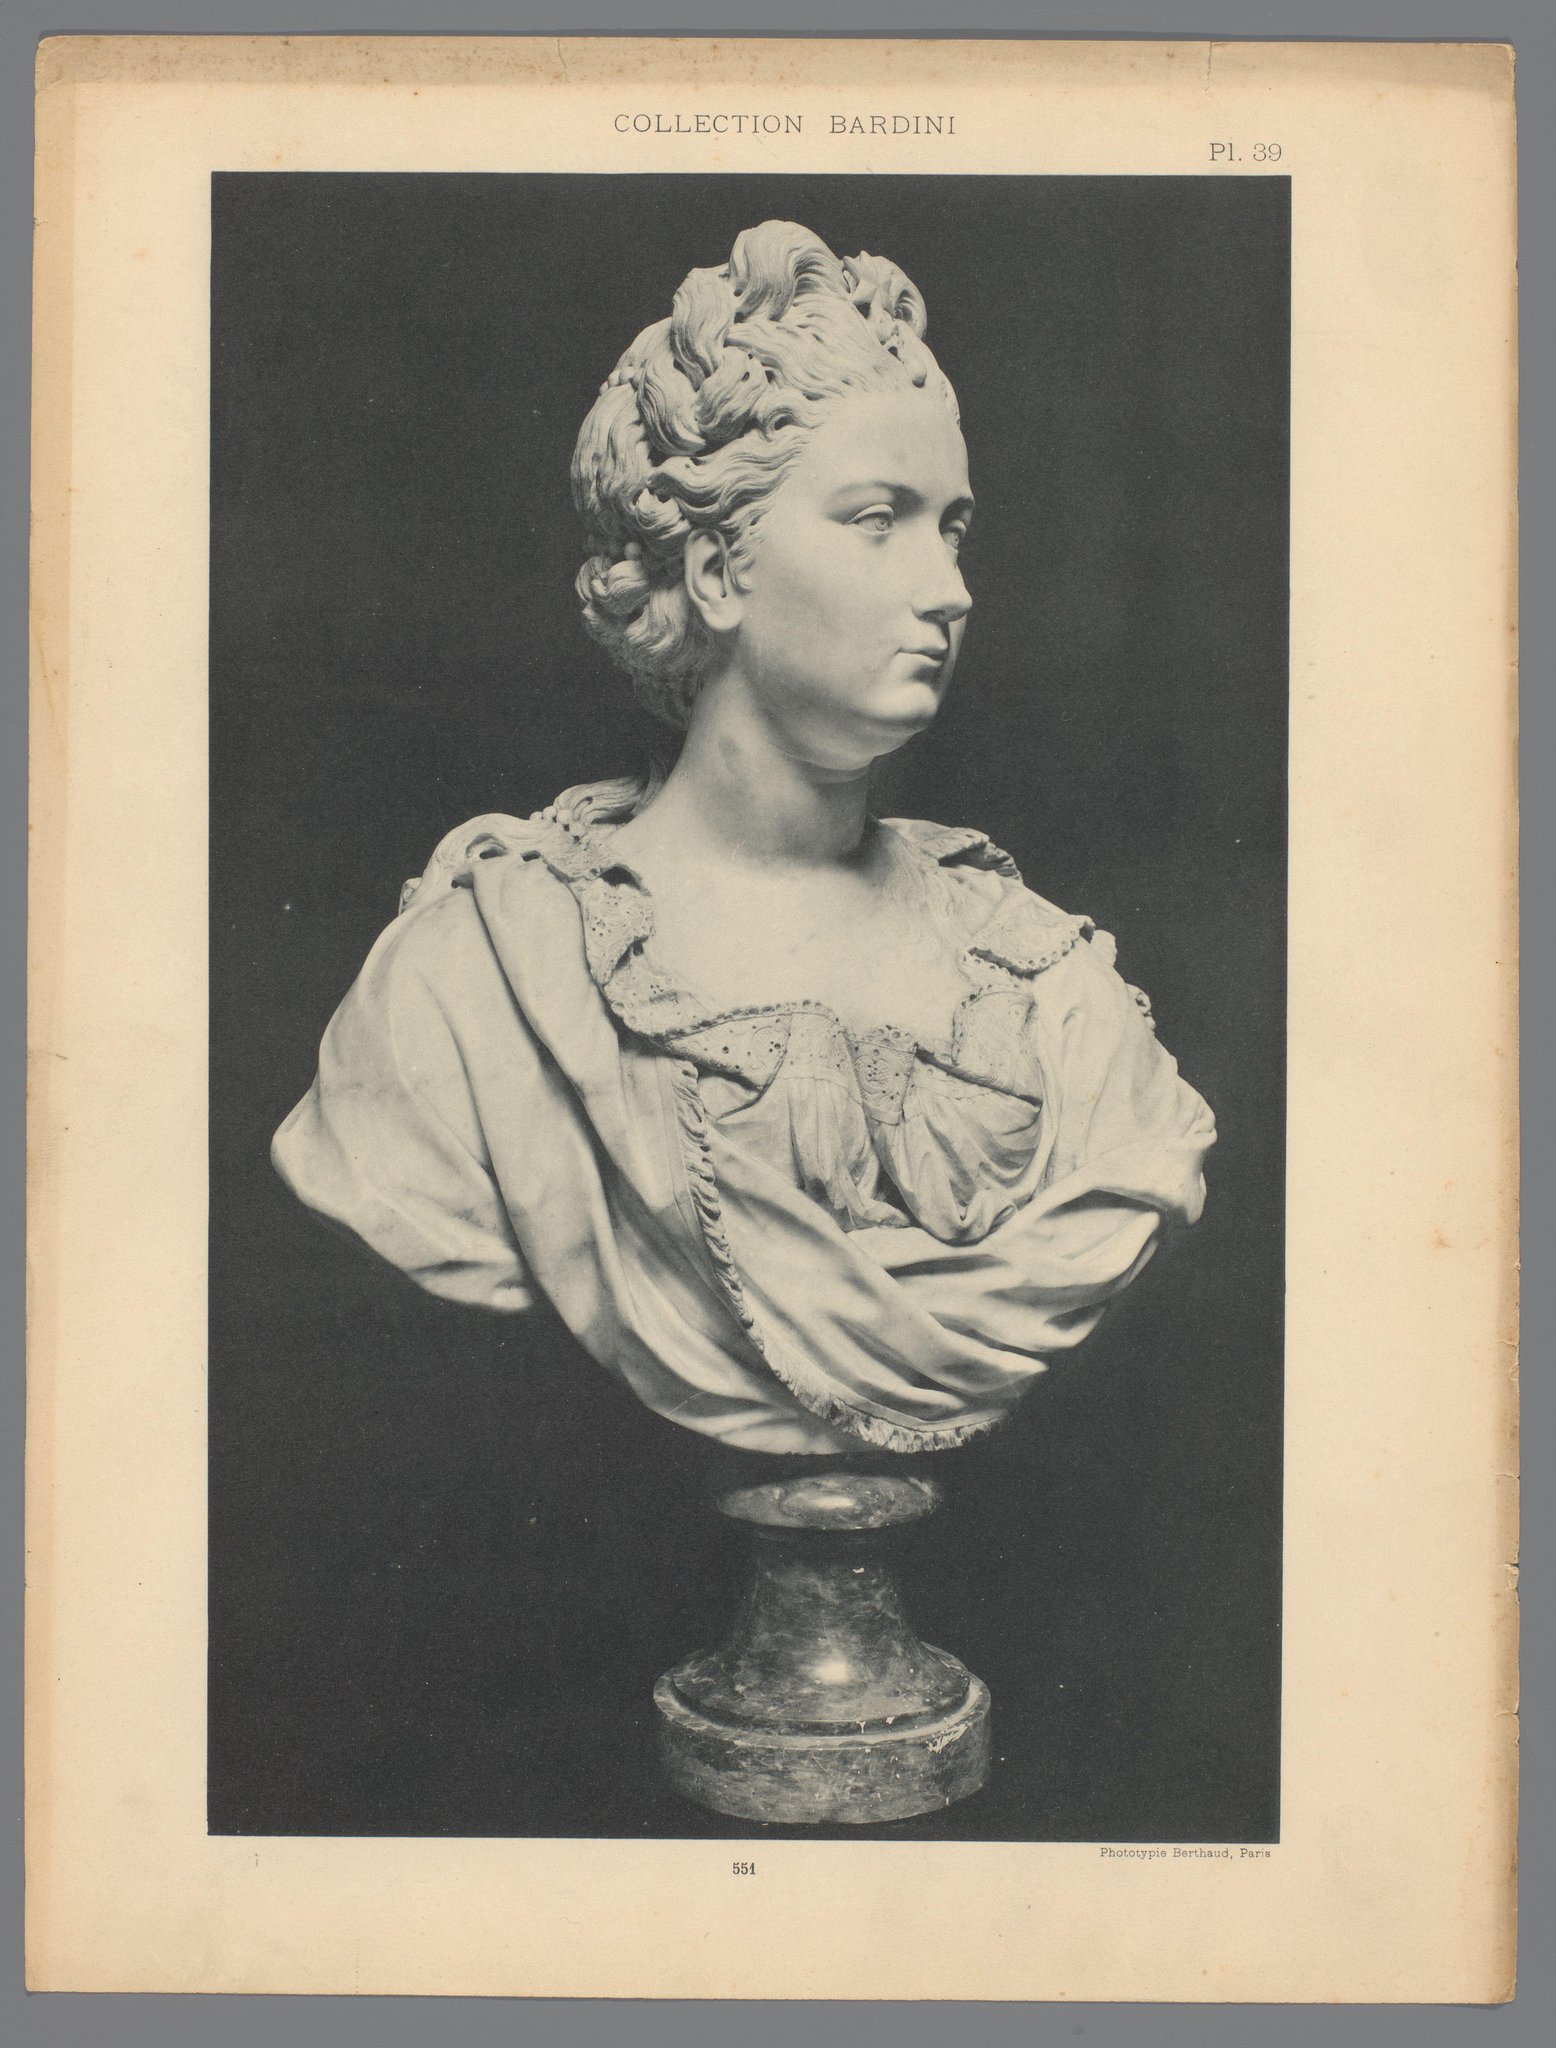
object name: photomechanical print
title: Buste van een onbekende vrouw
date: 1875-1912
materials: paper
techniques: photograph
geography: paris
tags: sculpture, anonymous historical person portrayed - bb - woman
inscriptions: number: ‘Pl. 39’